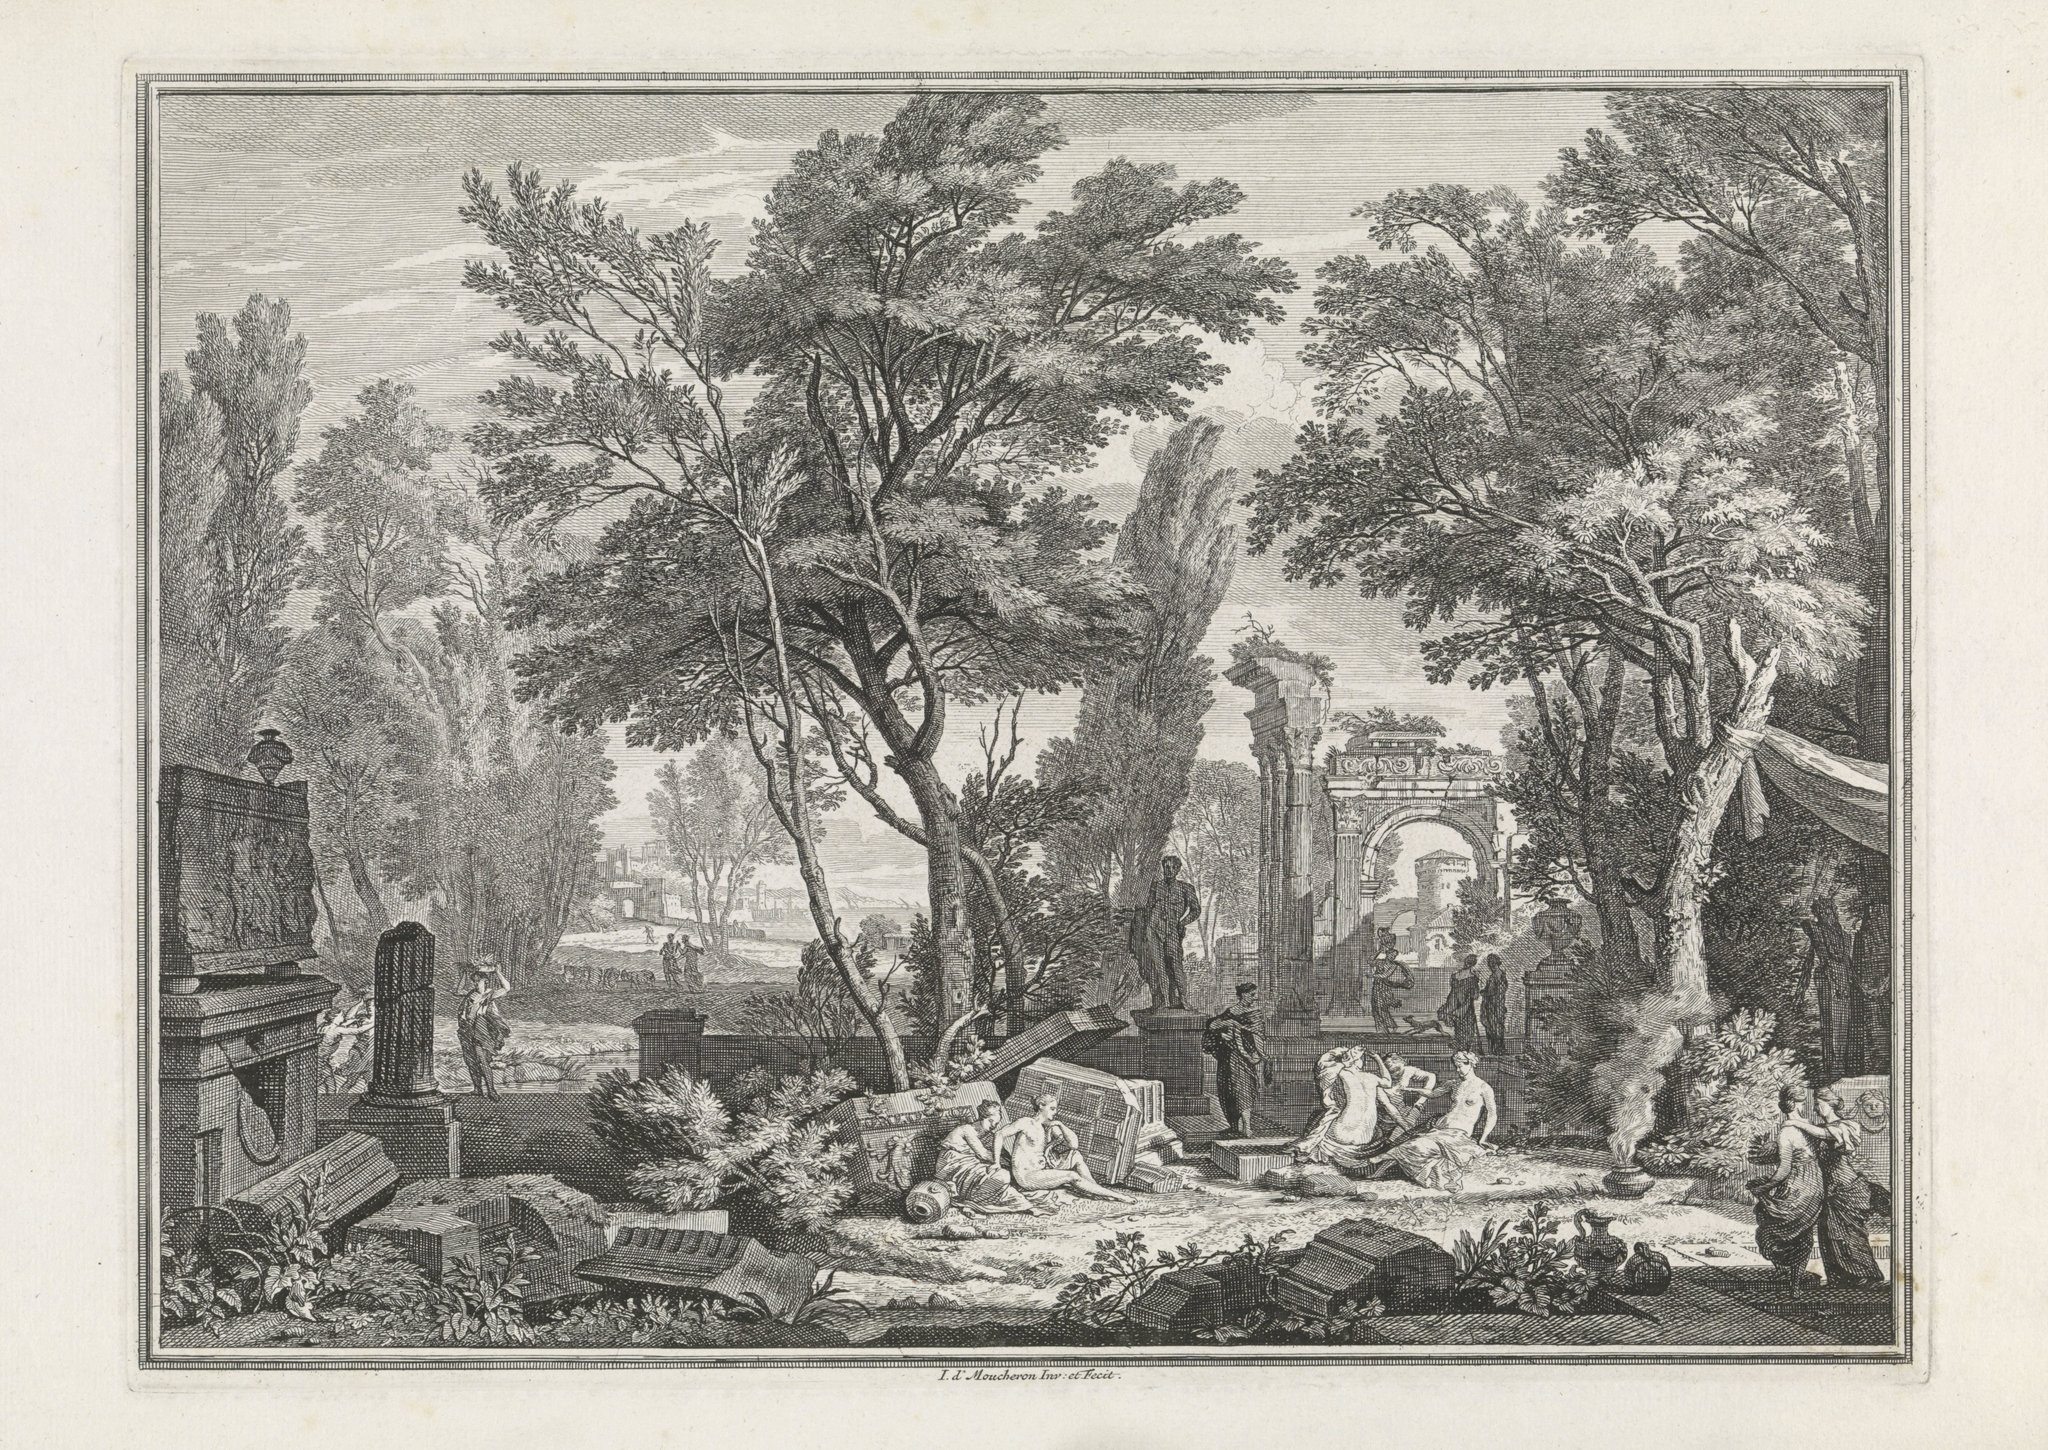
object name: print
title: Landschap met ruïnes en figuren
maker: isaac de moucheron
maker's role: draughtsman, painter, print maker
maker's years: 1667-1744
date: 1687-1744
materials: paper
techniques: engraving, etching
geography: amsterdam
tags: landscape with ruins, monument, statue, pastorals, arcadian scenes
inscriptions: collector's mark: Lugt 240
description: Landschap met klassieke sculpturen en diverse fragmenten van gebouwen. Daarbij zitten groepjes halfnaakte vrouwen. Rechts op de achtergrond een boog.